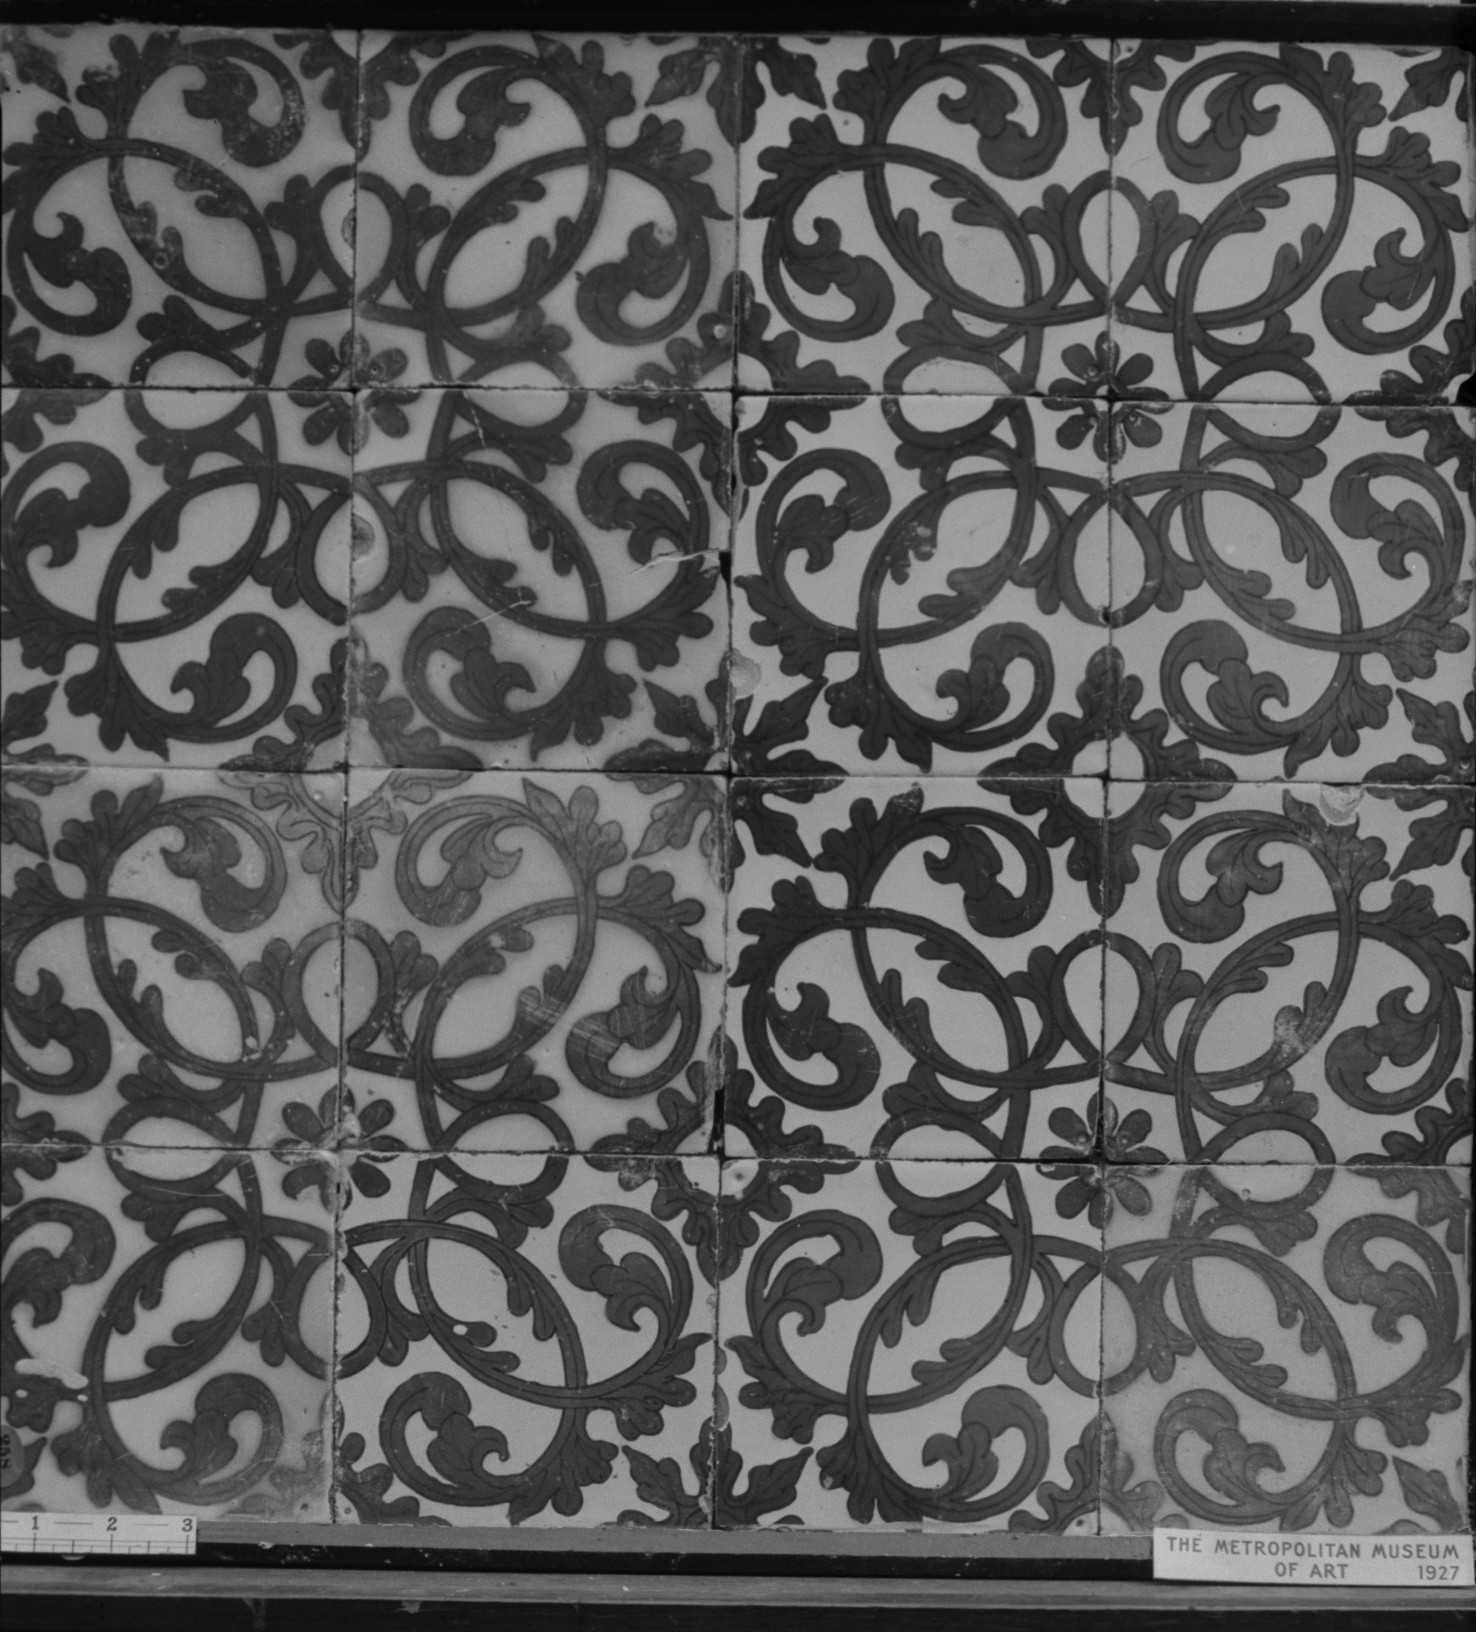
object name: tile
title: Tiles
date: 1601-1700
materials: earthenware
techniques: glazing